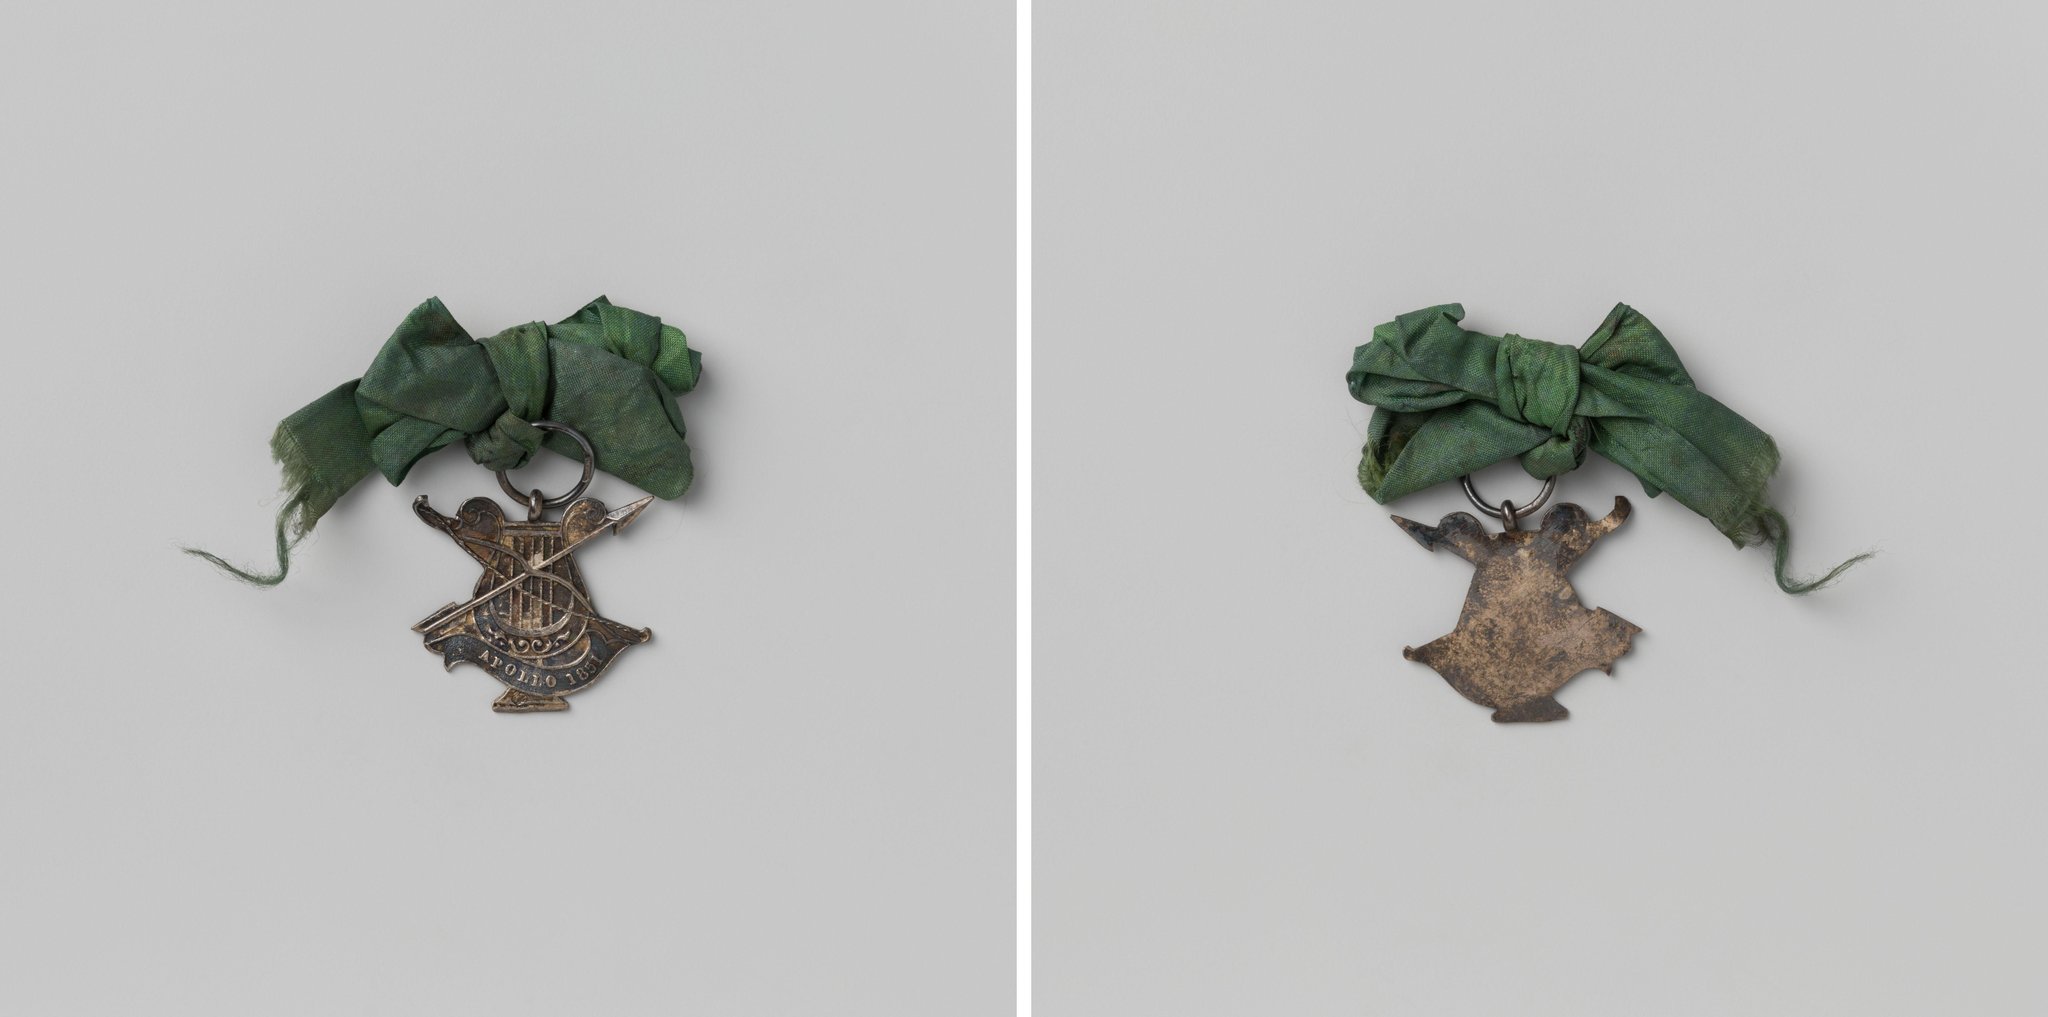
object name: insignia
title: Zangvereniging 'Apollo'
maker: Anonymous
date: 1851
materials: silver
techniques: striking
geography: netherlands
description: Eenzijdig draagteken in vorm van lier, waarover gekruiste pijl en boog liggen aan draagoog, draagring en gestrikt groen lint.